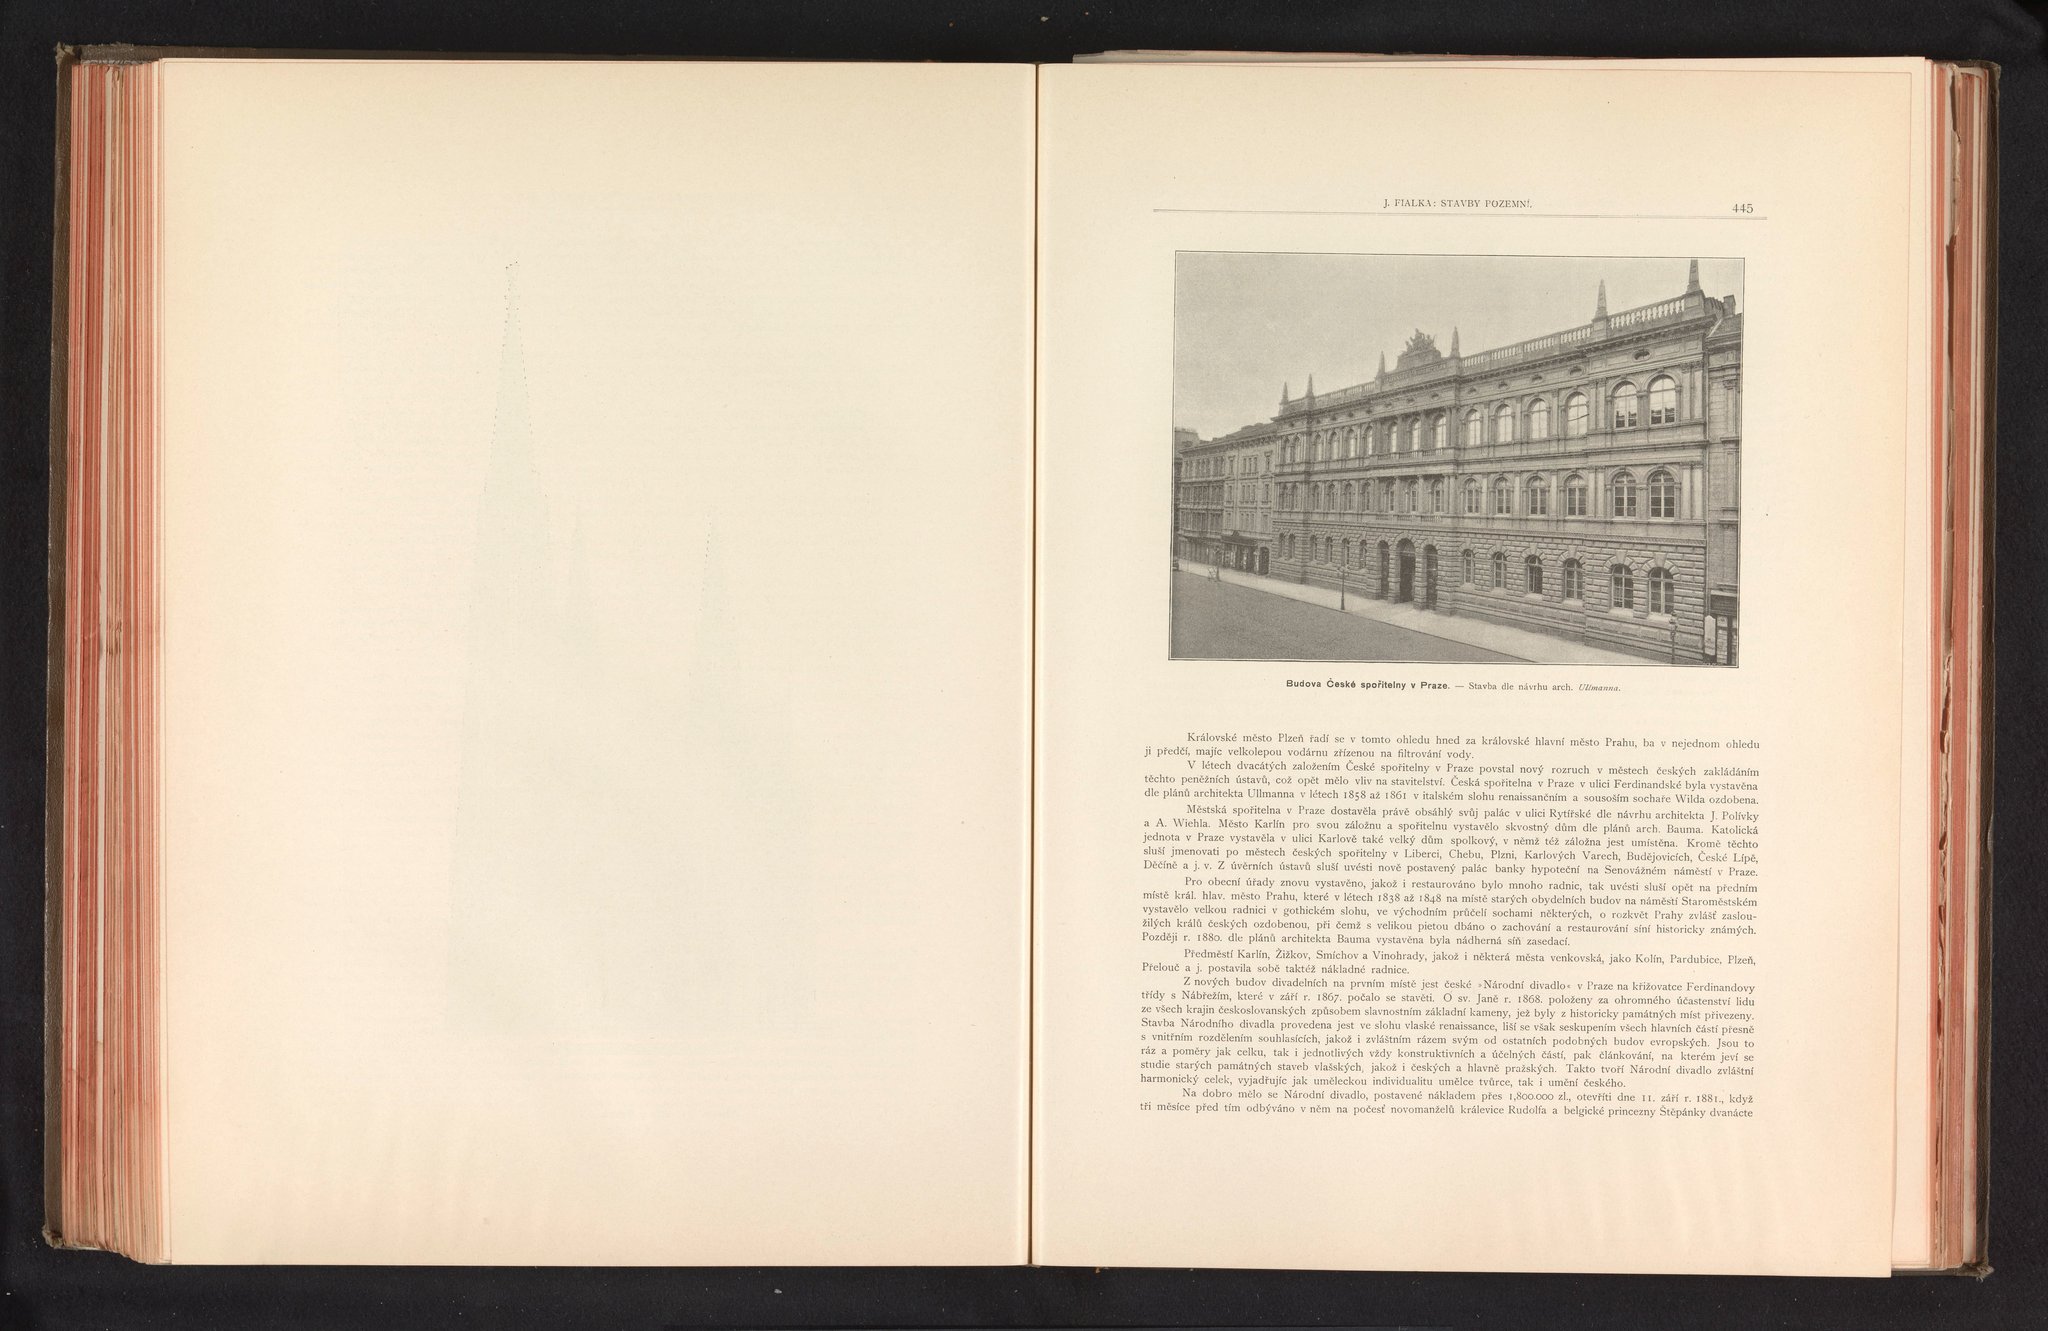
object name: photomechanical print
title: Budova Ceské sporitelny v Praze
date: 1891-1895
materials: paper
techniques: autotype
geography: prague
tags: façade (of house or building), bank